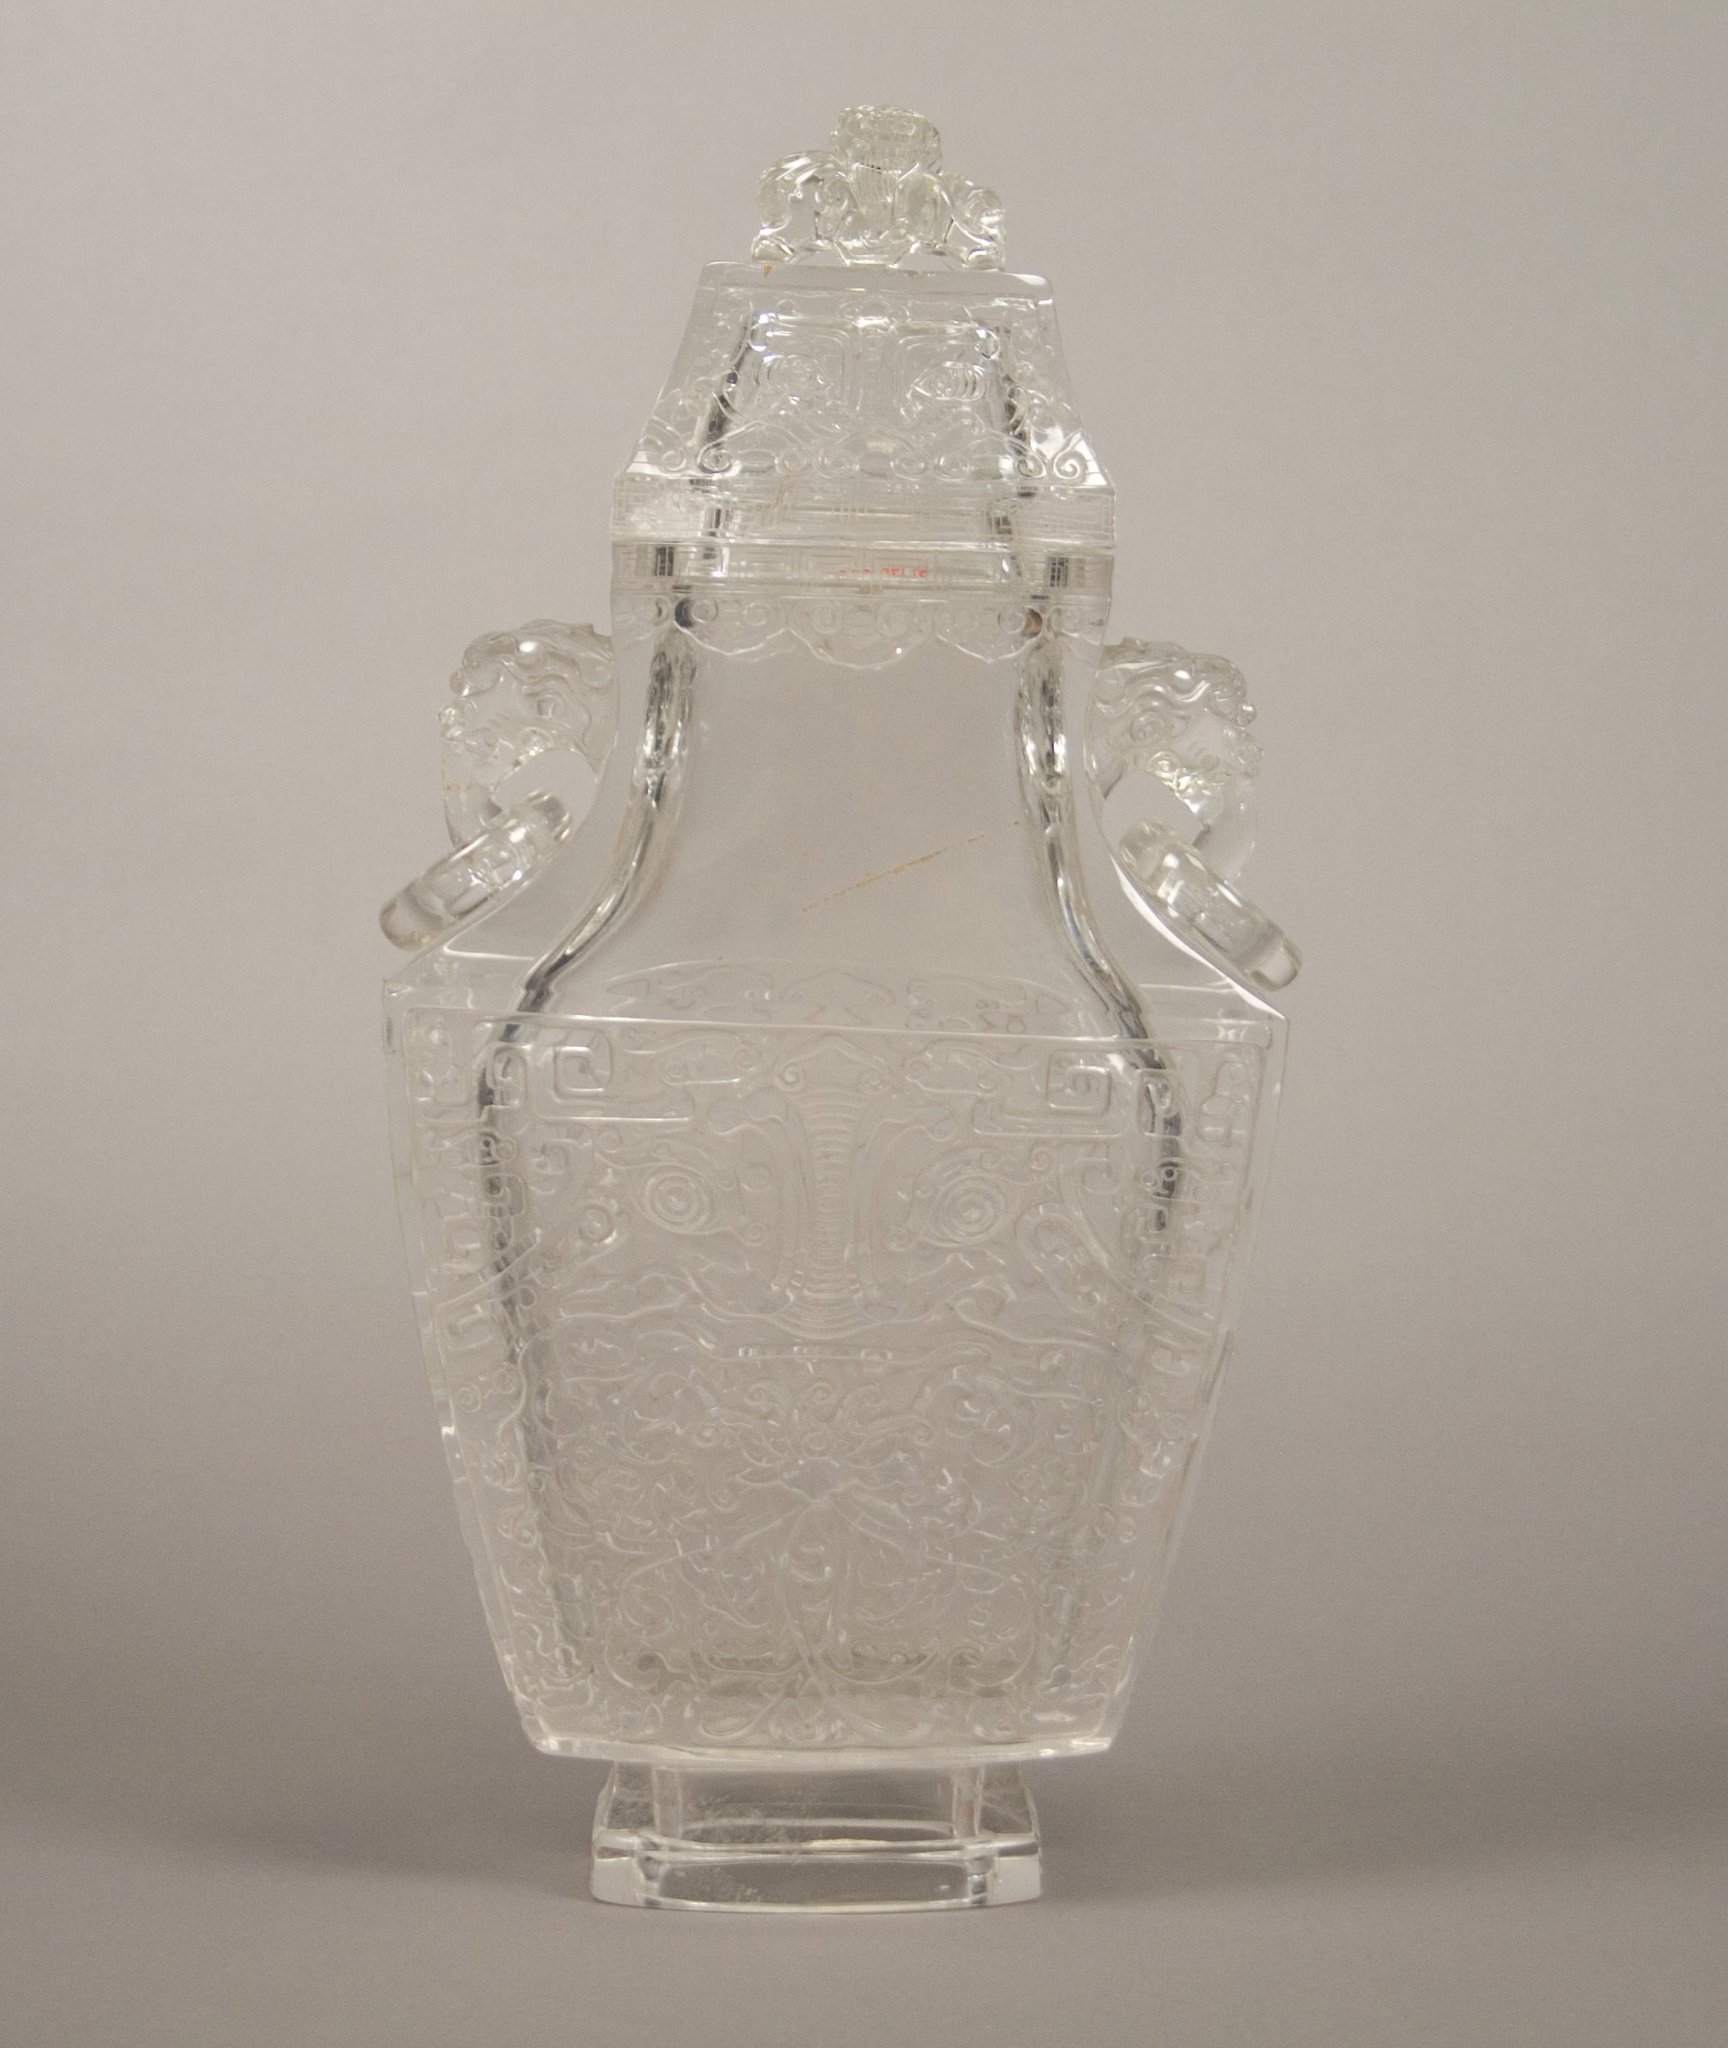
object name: covered vase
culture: chinese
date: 1736-1795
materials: crystal